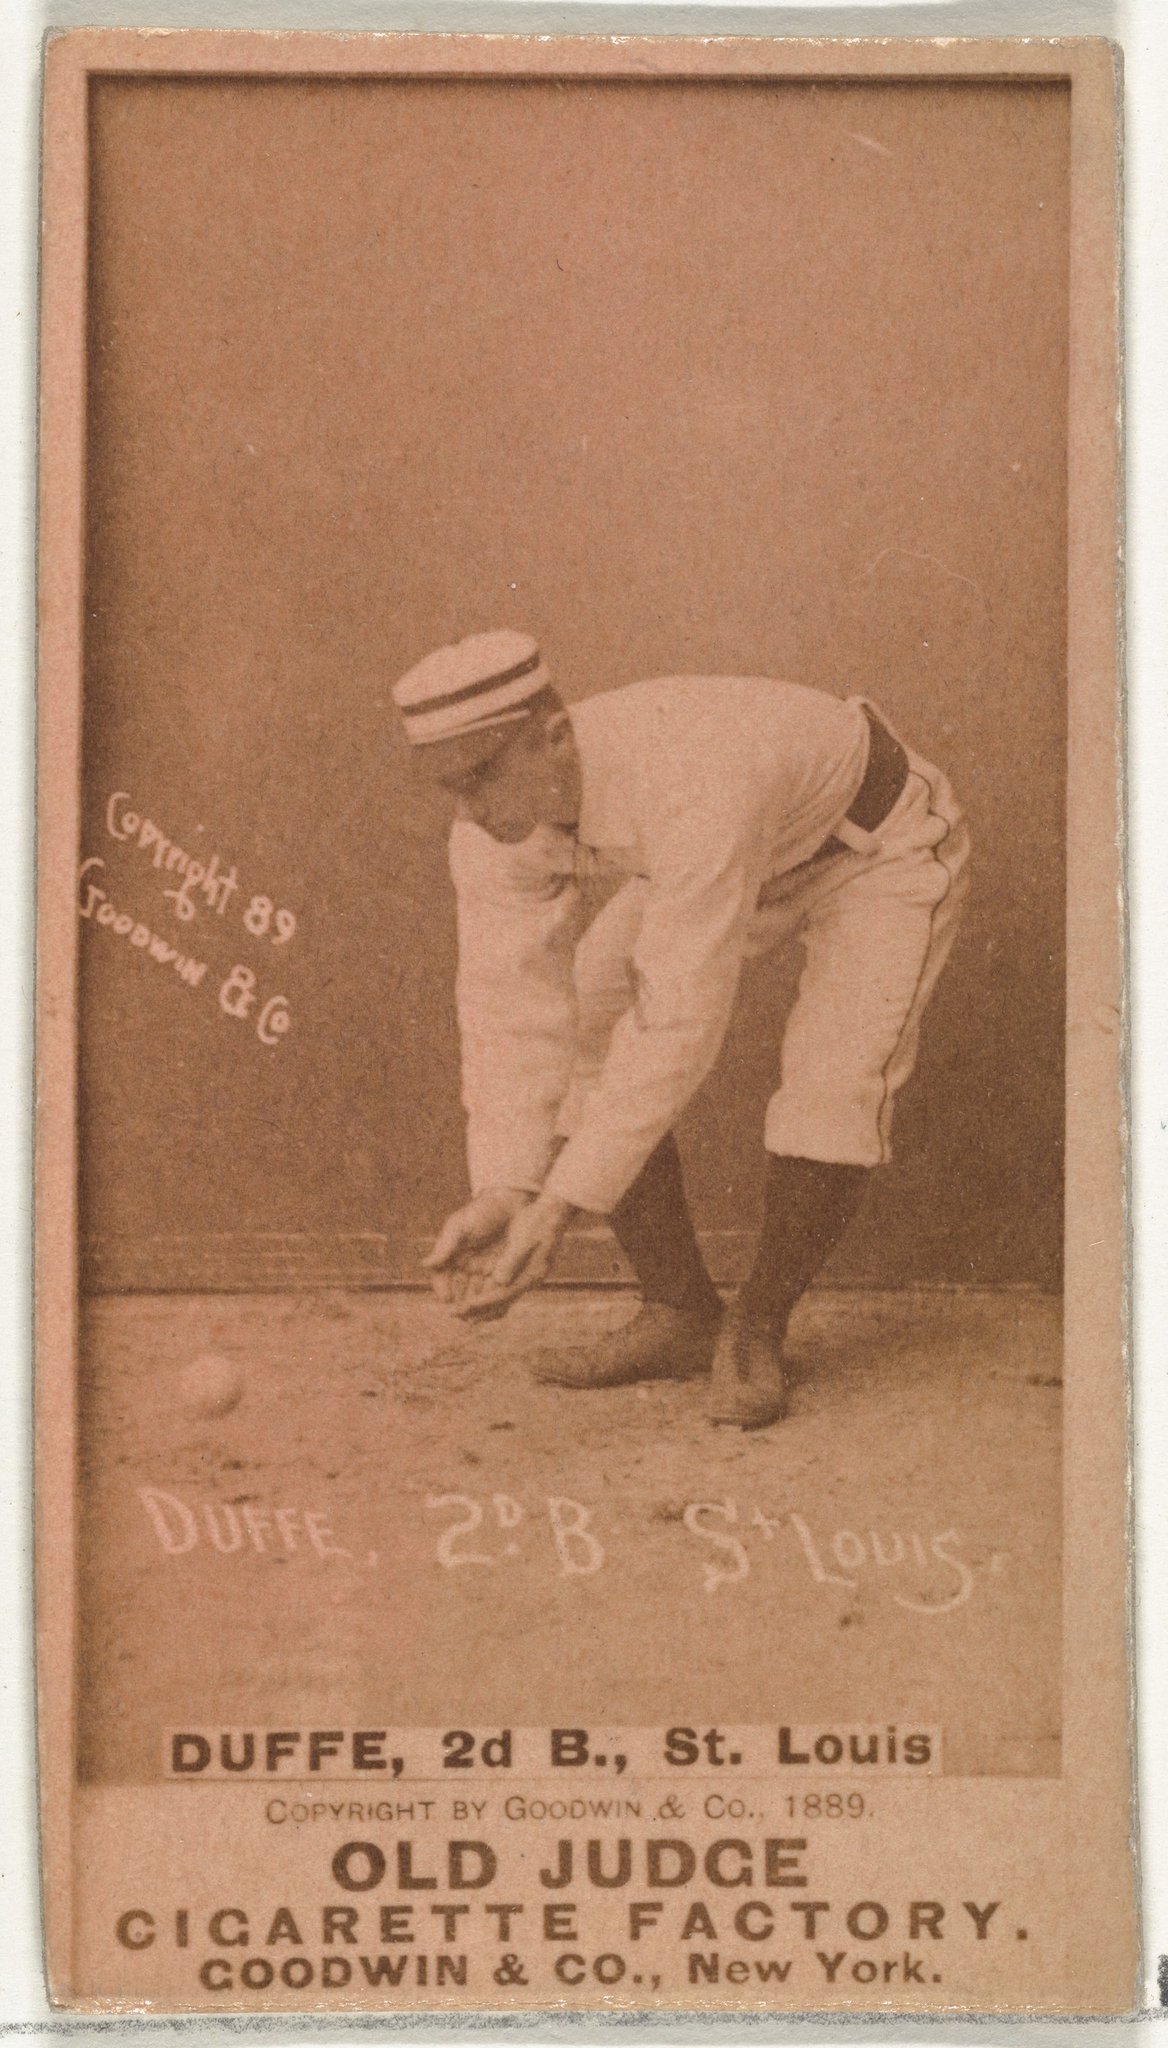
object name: baseball card, photograph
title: Charles Edward "Charlie" Duffee, 2nd Base, St. Louis Browns, from the Old Judge series (N172) for Old Judge Cigarettes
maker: goodwin & company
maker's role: publisher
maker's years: 1850-1950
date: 1889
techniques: albumen silver print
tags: men,portraits,baseball,athletes